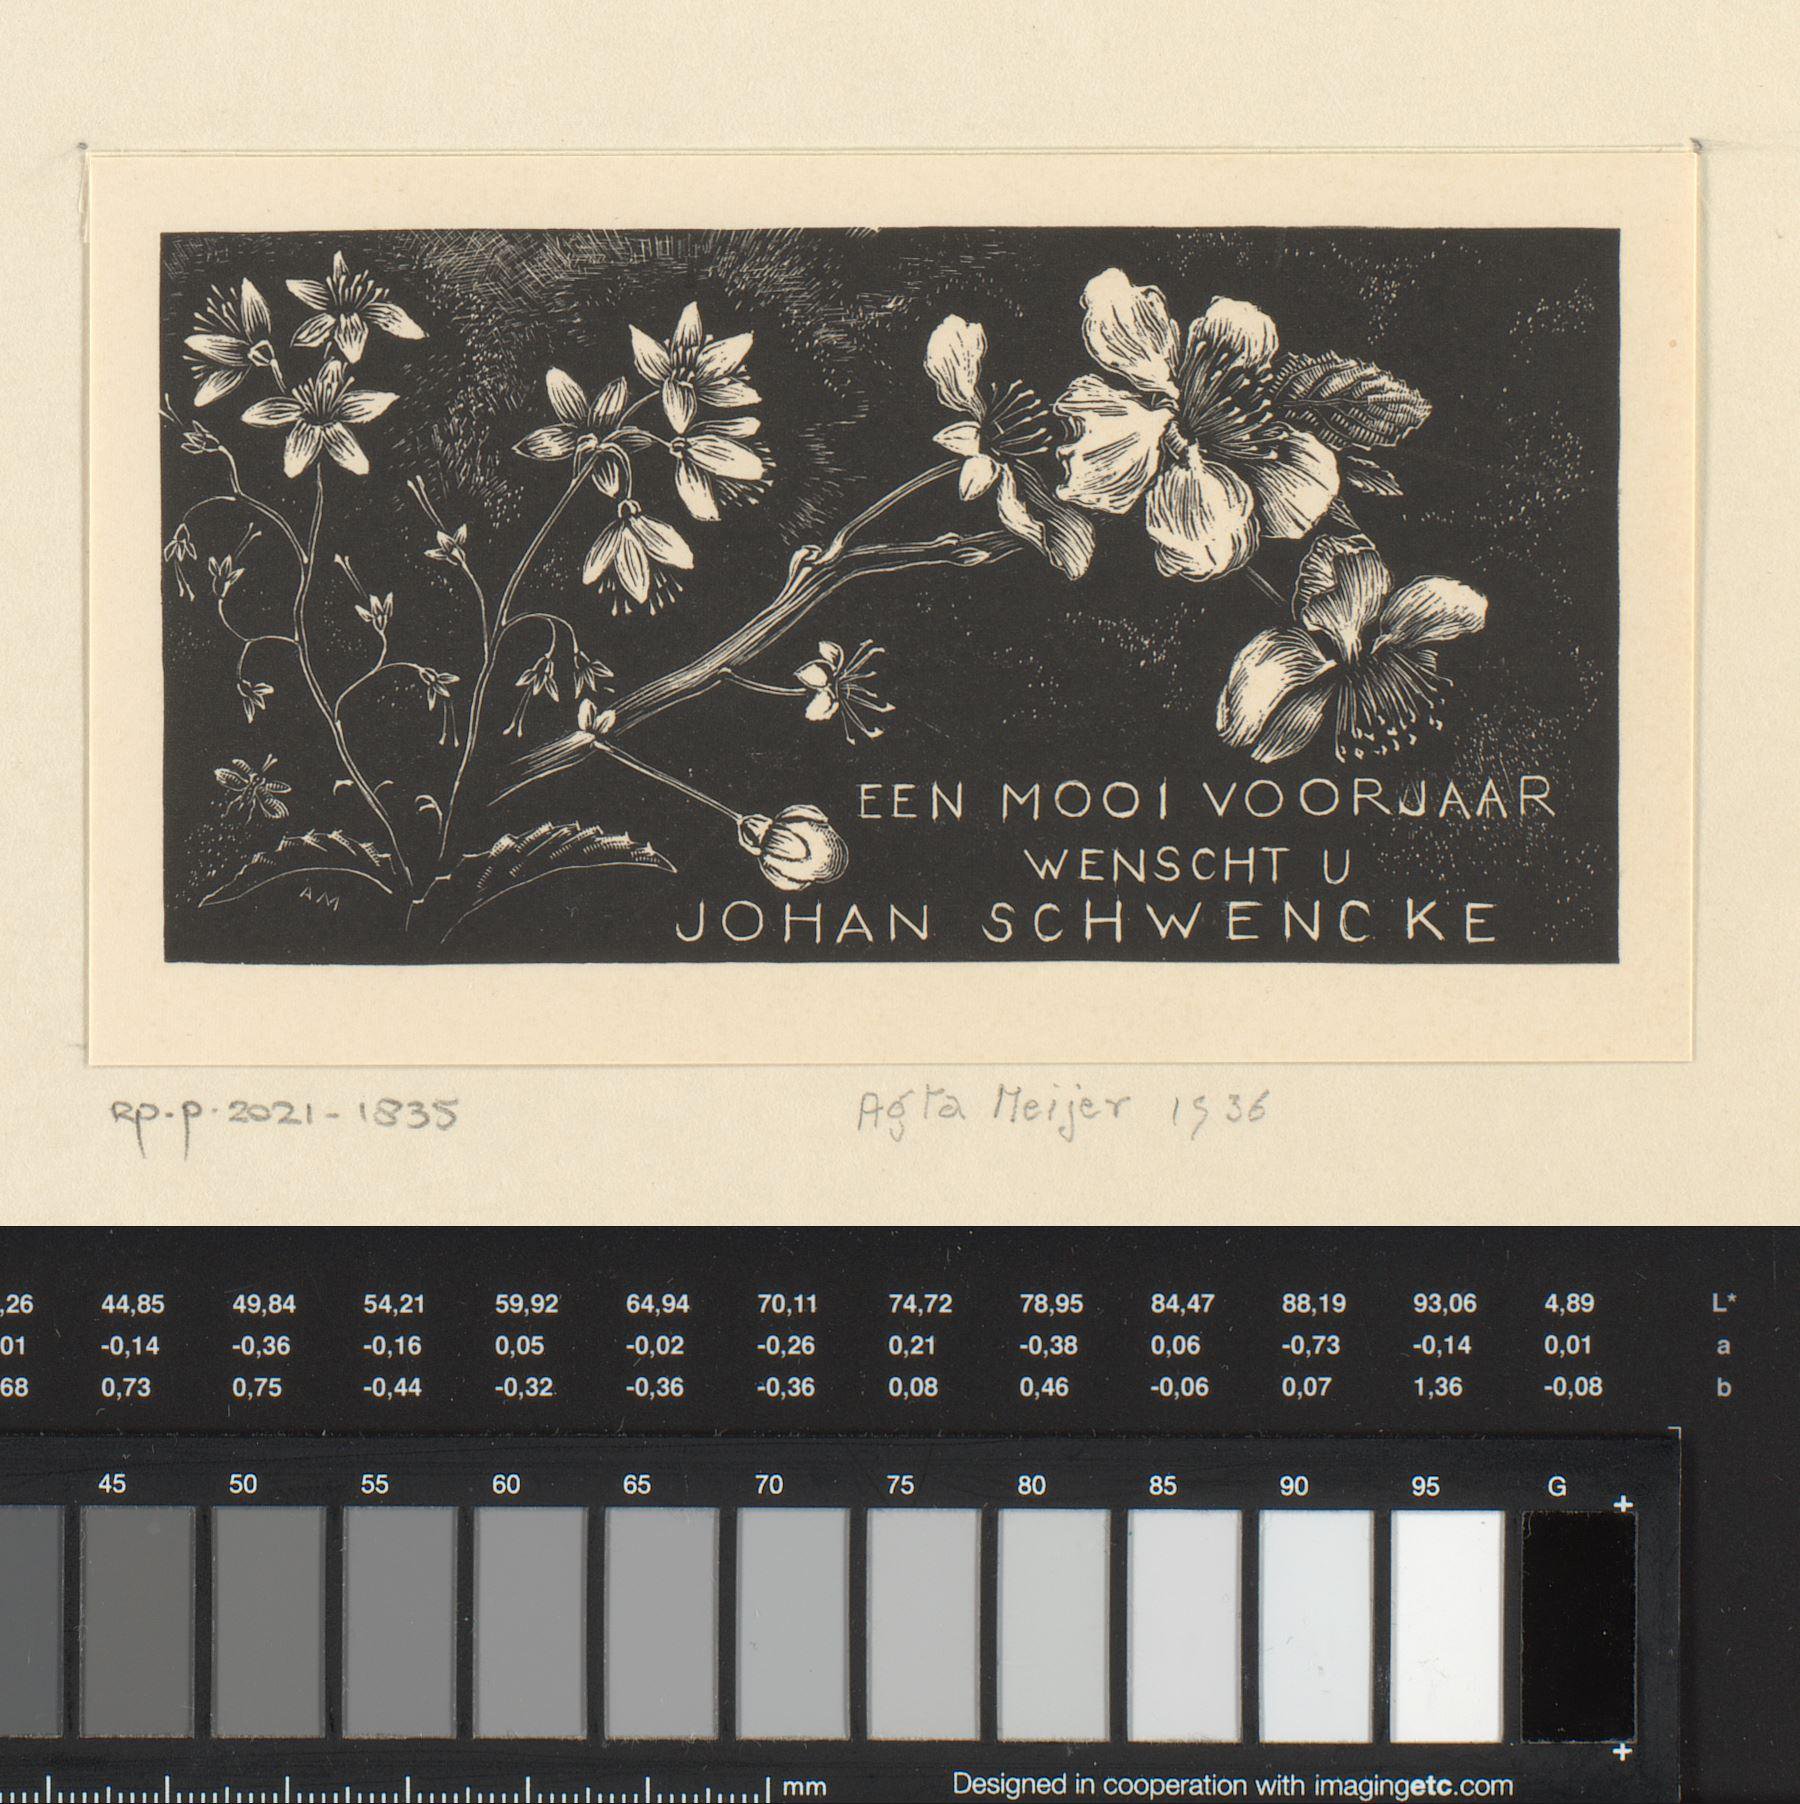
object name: print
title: Paaskaart van Johan Schwencke voor 1936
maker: agta meijer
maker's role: painter, print maker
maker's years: 1908-1944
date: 1936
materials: paper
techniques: engraving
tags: johannes jacobus schwencke (johan), flowers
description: Paaskaart met een bloeiende bloem en de tekst 'Een mooi voorjaar wenscht u Johan Schwencke'.